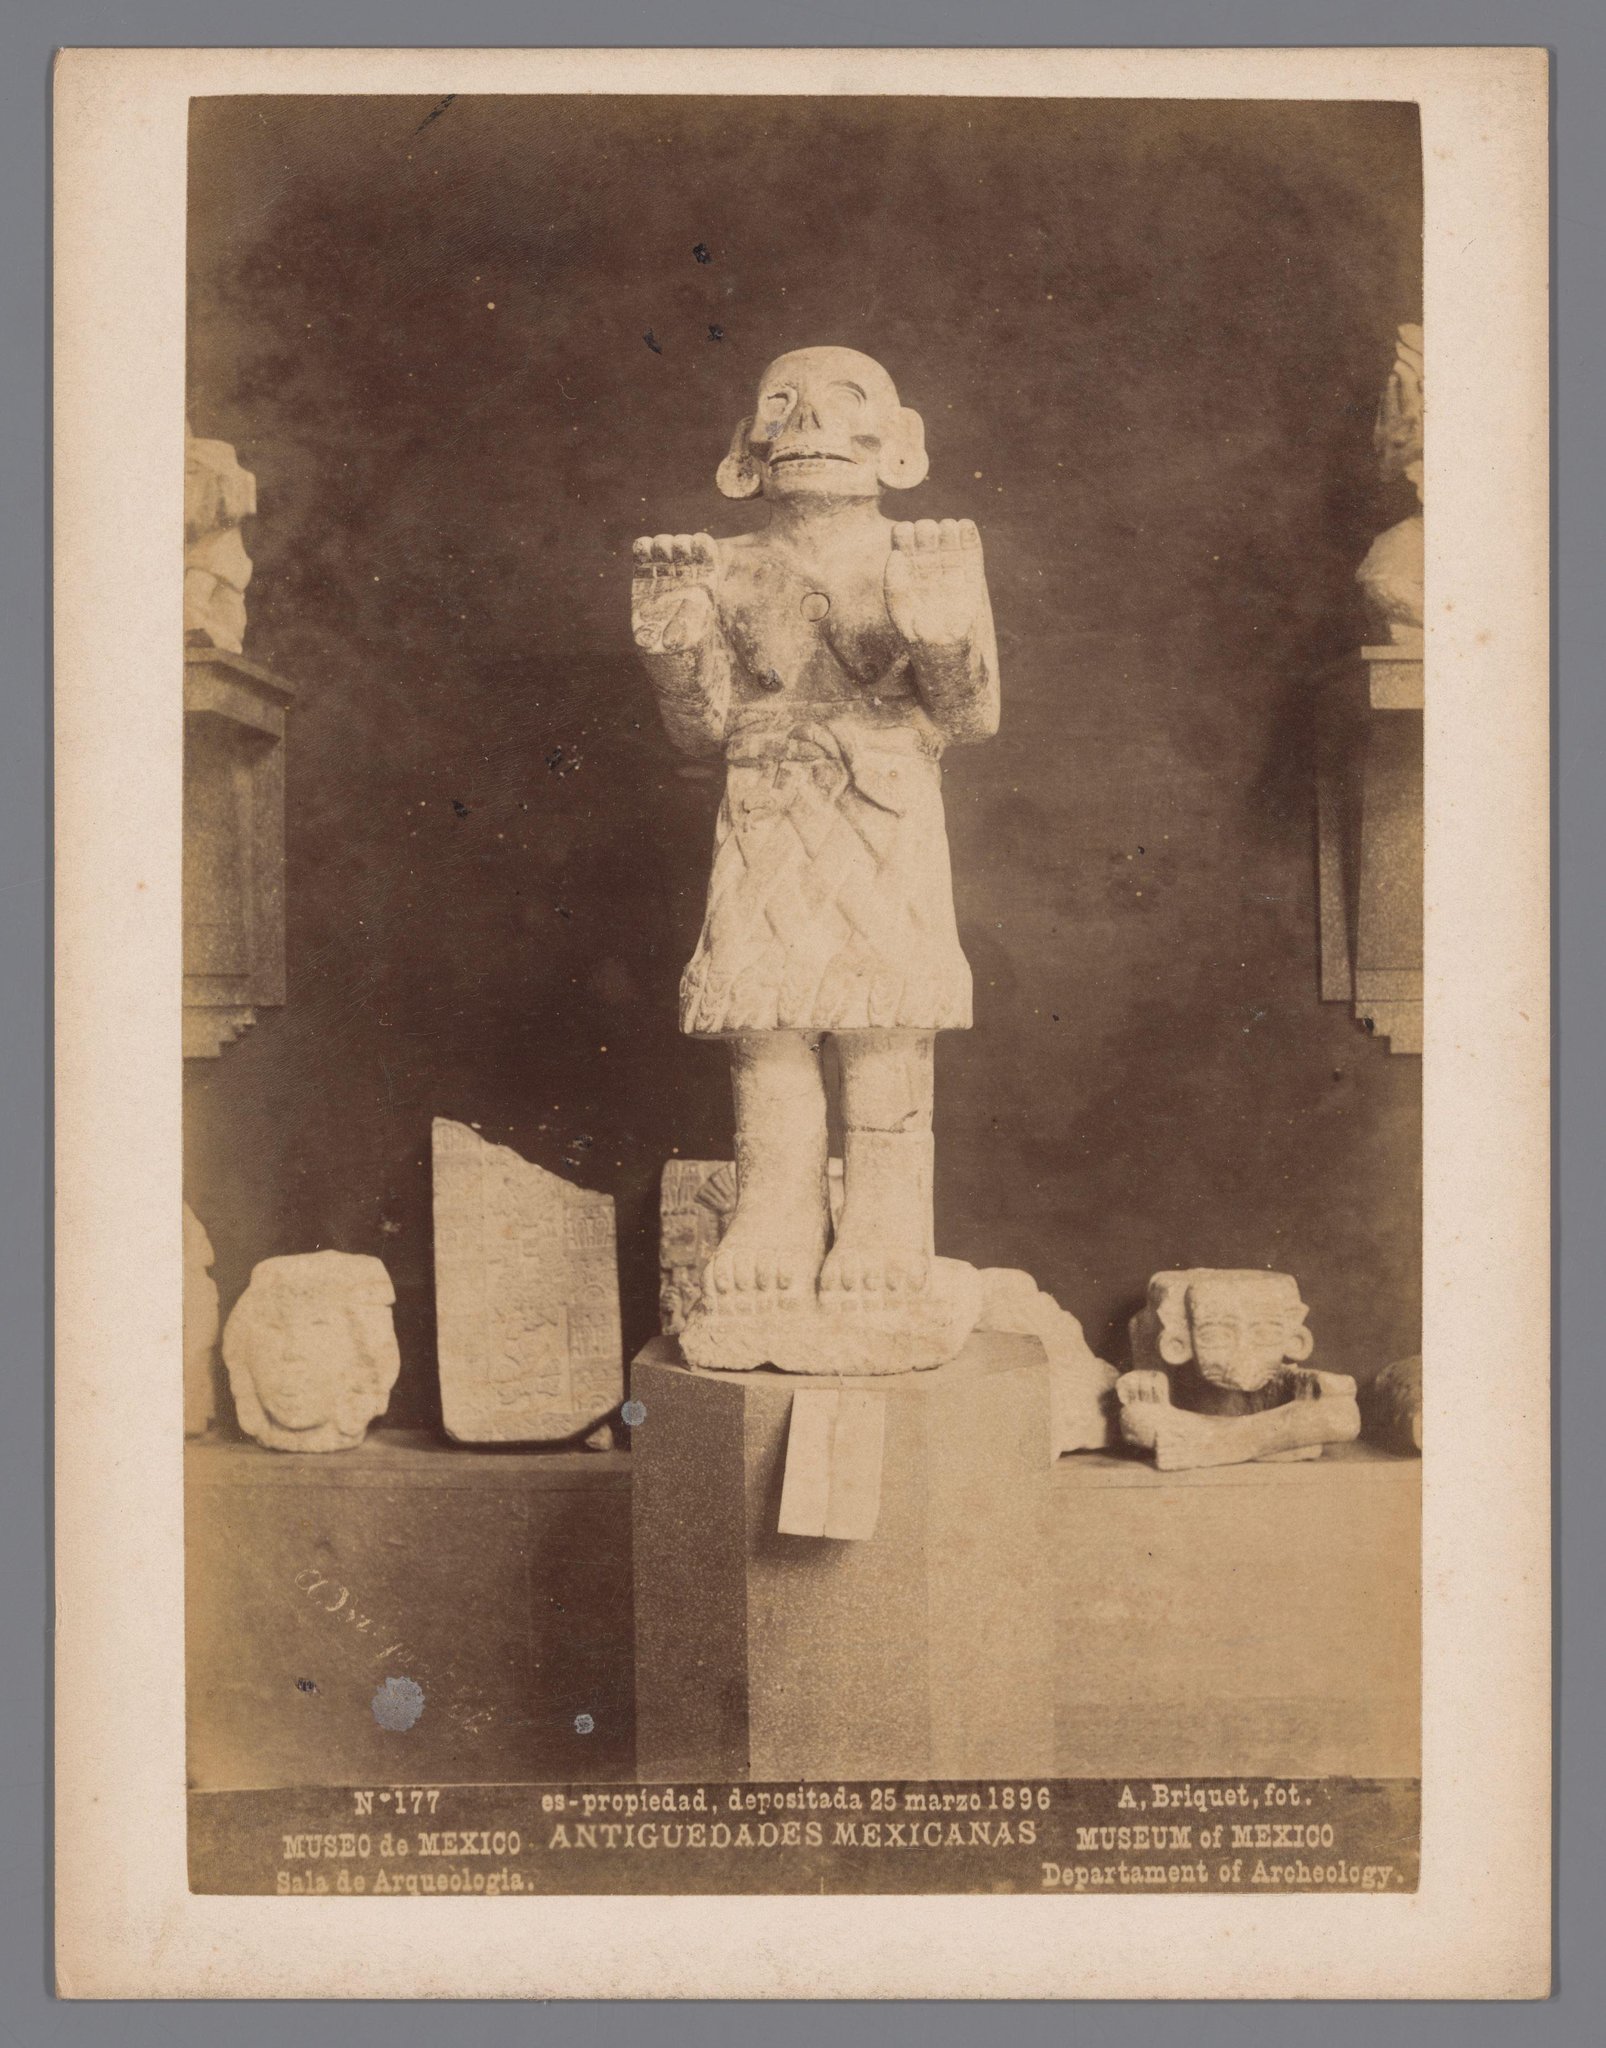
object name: photograph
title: Antiguedades Mexicanas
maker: abel briquet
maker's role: fotograaf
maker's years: 1833-1926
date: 1896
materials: cardboard, paper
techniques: albumen print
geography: mexico city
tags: statues, paintings, etc. ~ objects of worship (non-christian religions)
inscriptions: number: ‘N. 177’, copyright notice: ‘es-propriedad, depositada 25 marzo 1896’